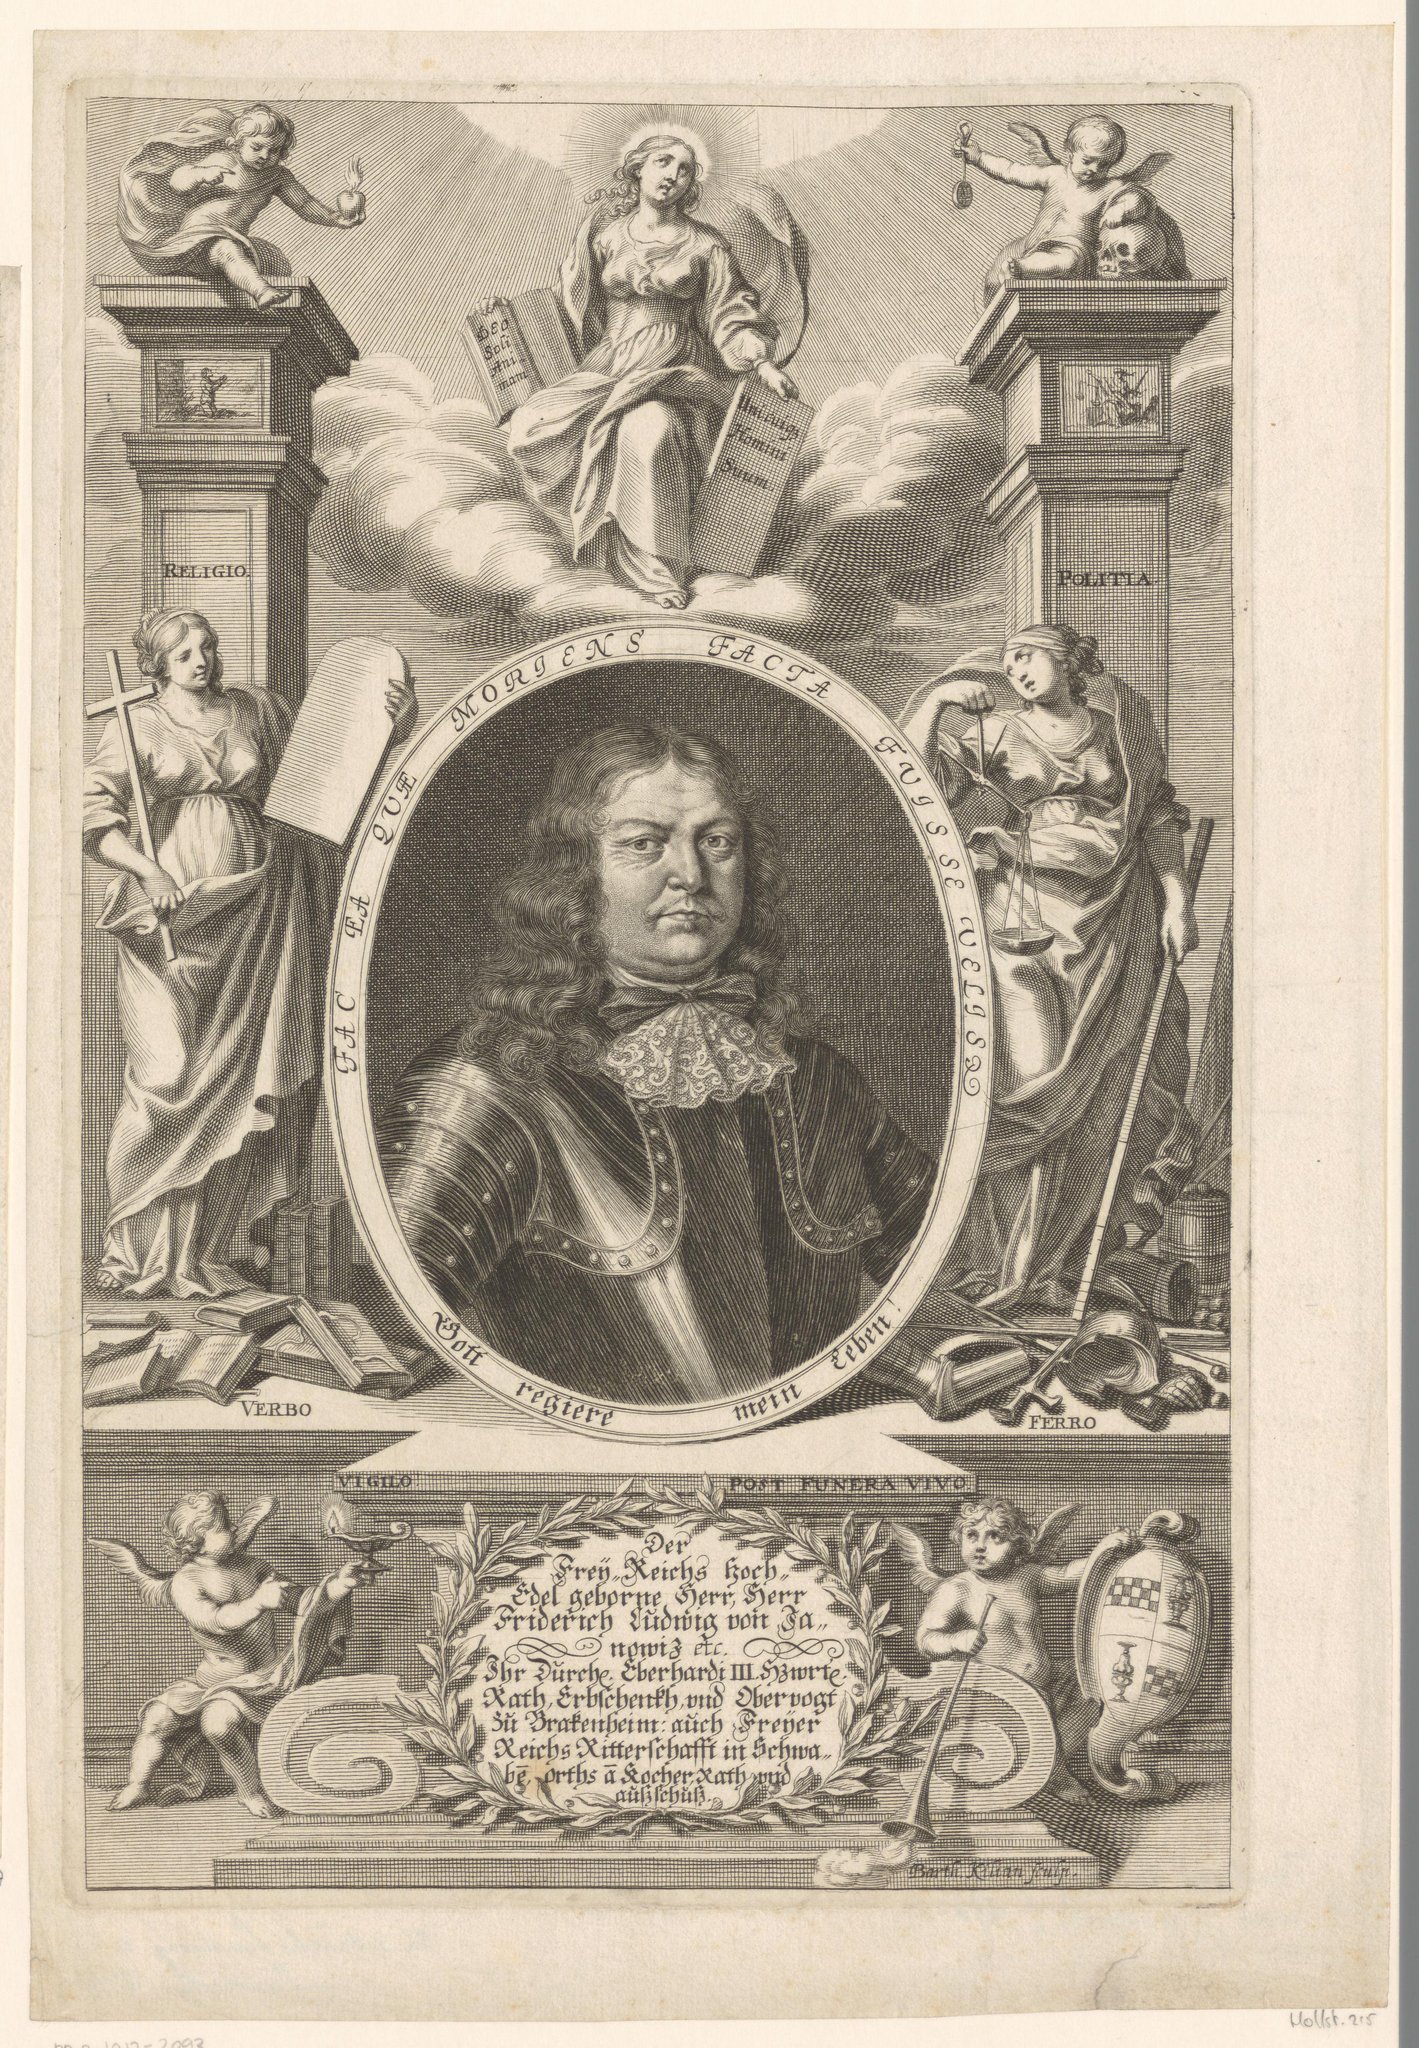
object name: print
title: Portret van Friedrich Ludwig von Janowitz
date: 1670-1696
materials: paper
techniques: engraving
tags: historical persons, counsellor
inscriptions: collector's mark: Lugt 2228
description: Personificaties van Religie en Politiek, engelen en vanitas symboliek omringen het portret medaillon. Tekst in het Duits in de marge.